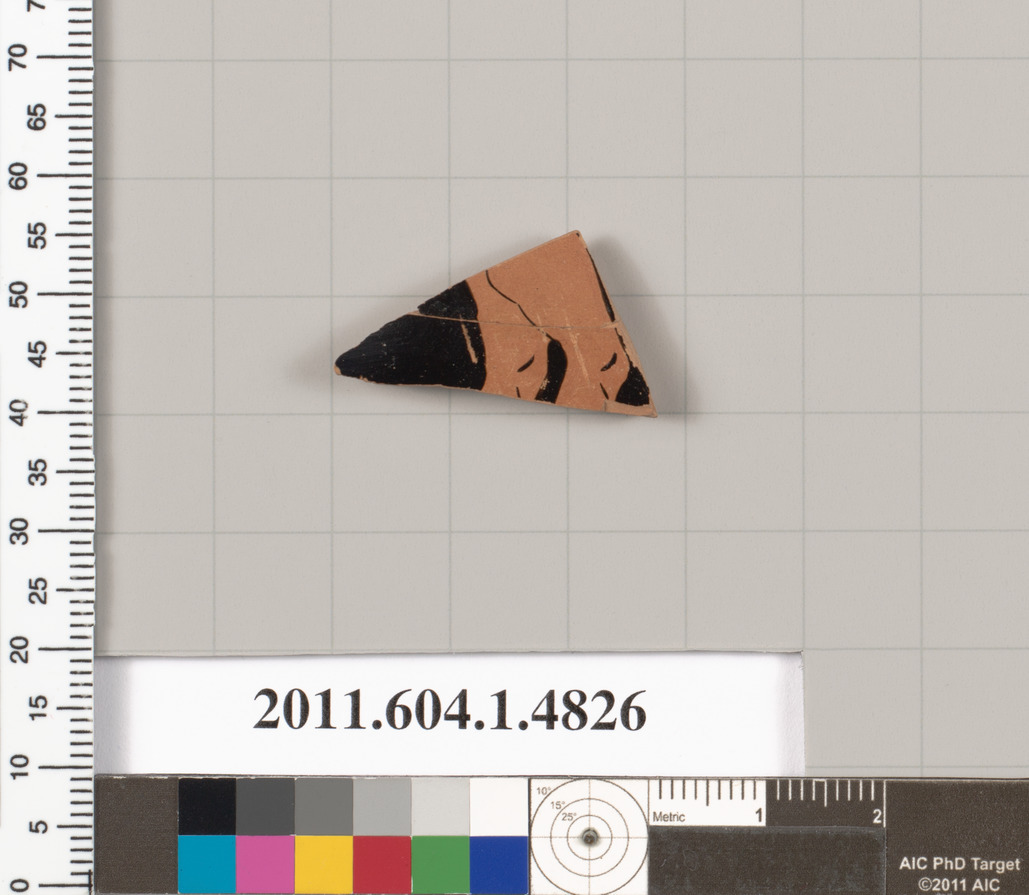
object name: kylix fragment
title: Terracotta fragment of a kylix (drinking cup)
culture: greek, attic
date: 490-470 BCE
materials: terracotta